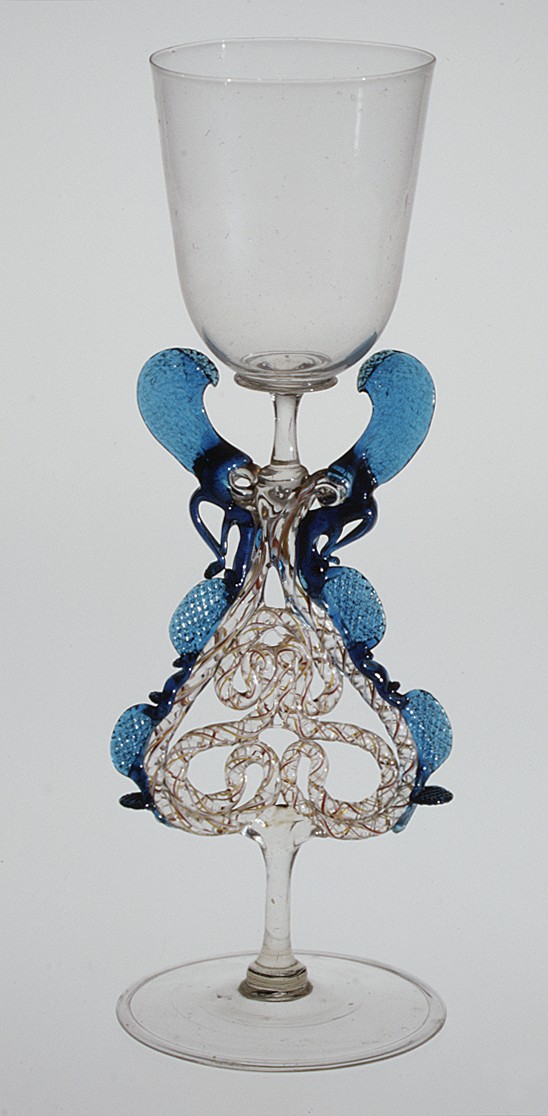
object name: goblet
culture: façon de venise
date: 1601-1700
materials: brick, glass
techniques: glassblowing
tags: serpents